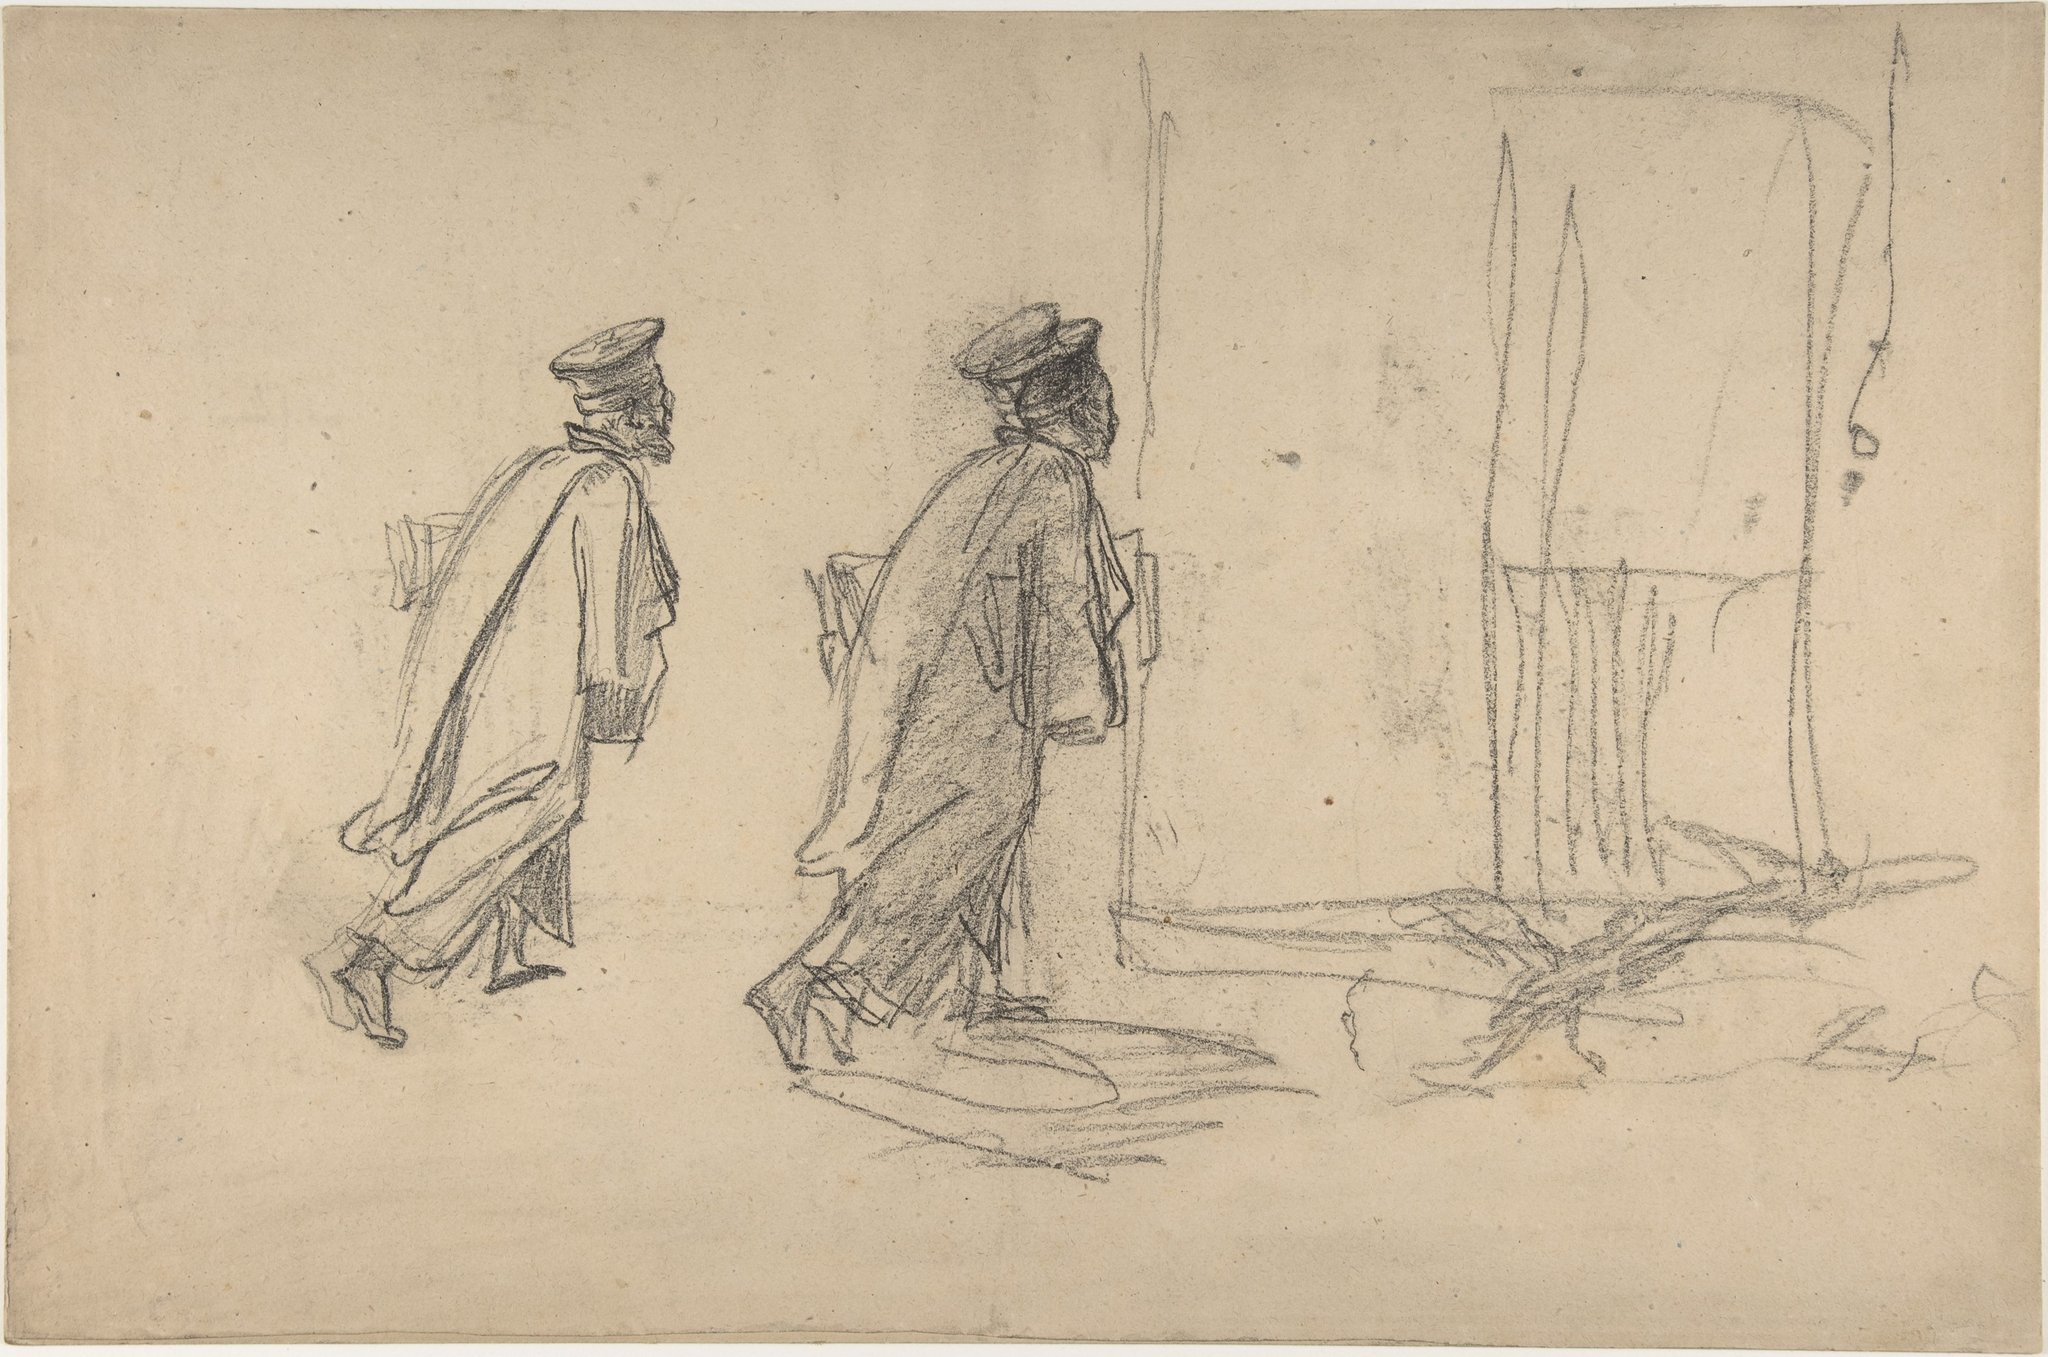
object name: drawing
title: Lawyer on His Way to Court (Se Rendant à l'Audience)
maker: thomas couture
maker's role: artist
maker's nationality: french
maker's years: 1815-1879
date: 1830-1879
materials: chalk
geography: france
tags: men,walking